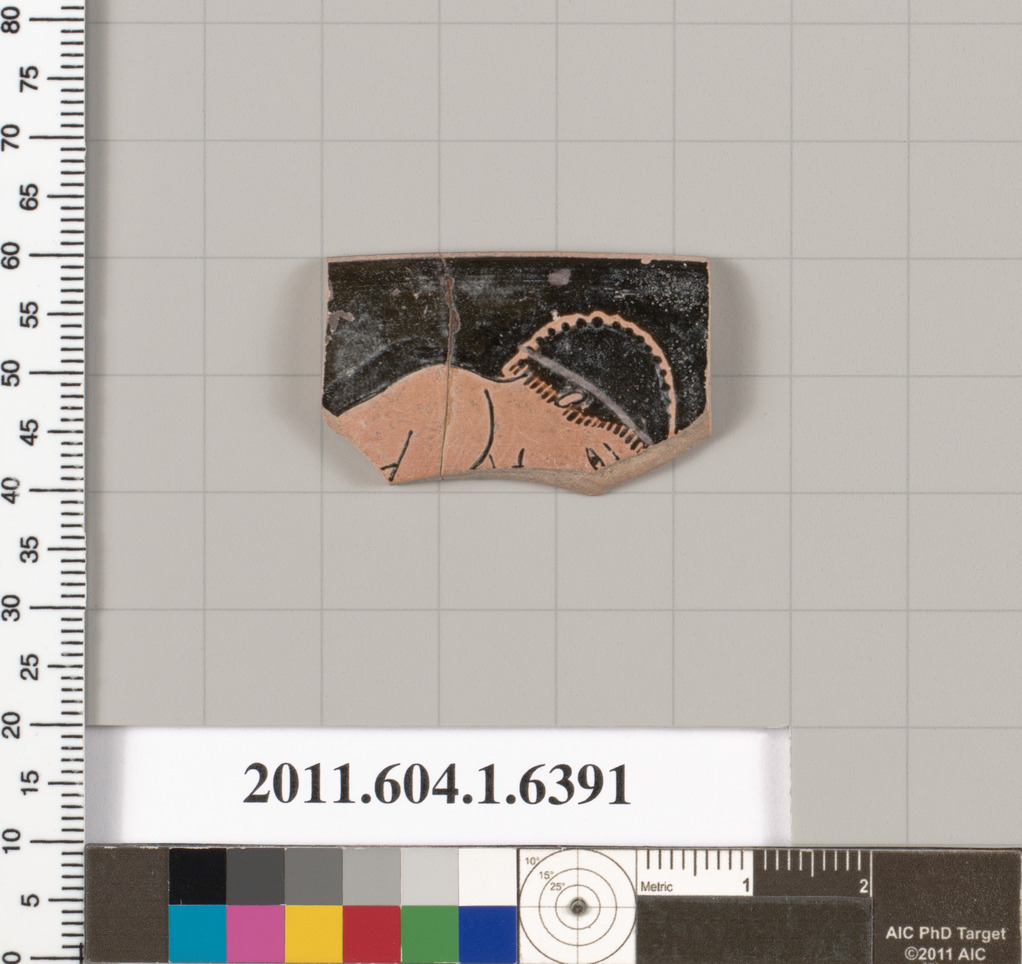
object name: kylix fragment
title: Terracotta rim fragment of a kylix (drinking cup)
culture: greek, attic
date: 490-480 BCE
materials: terracotta